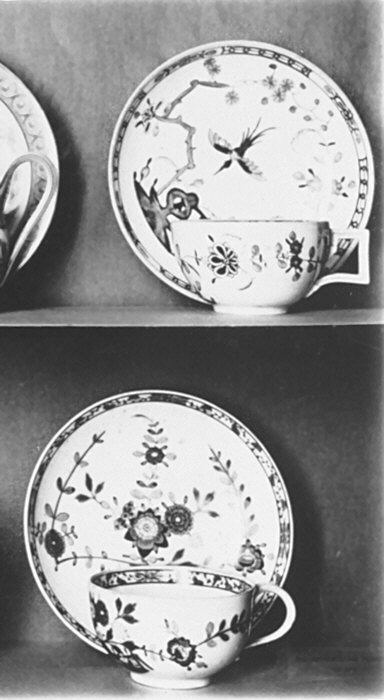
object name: saucer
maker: meissen manufactory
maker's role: manufactory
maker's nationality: german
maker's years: 1710-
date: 1701-1900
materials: hard paste porcelain